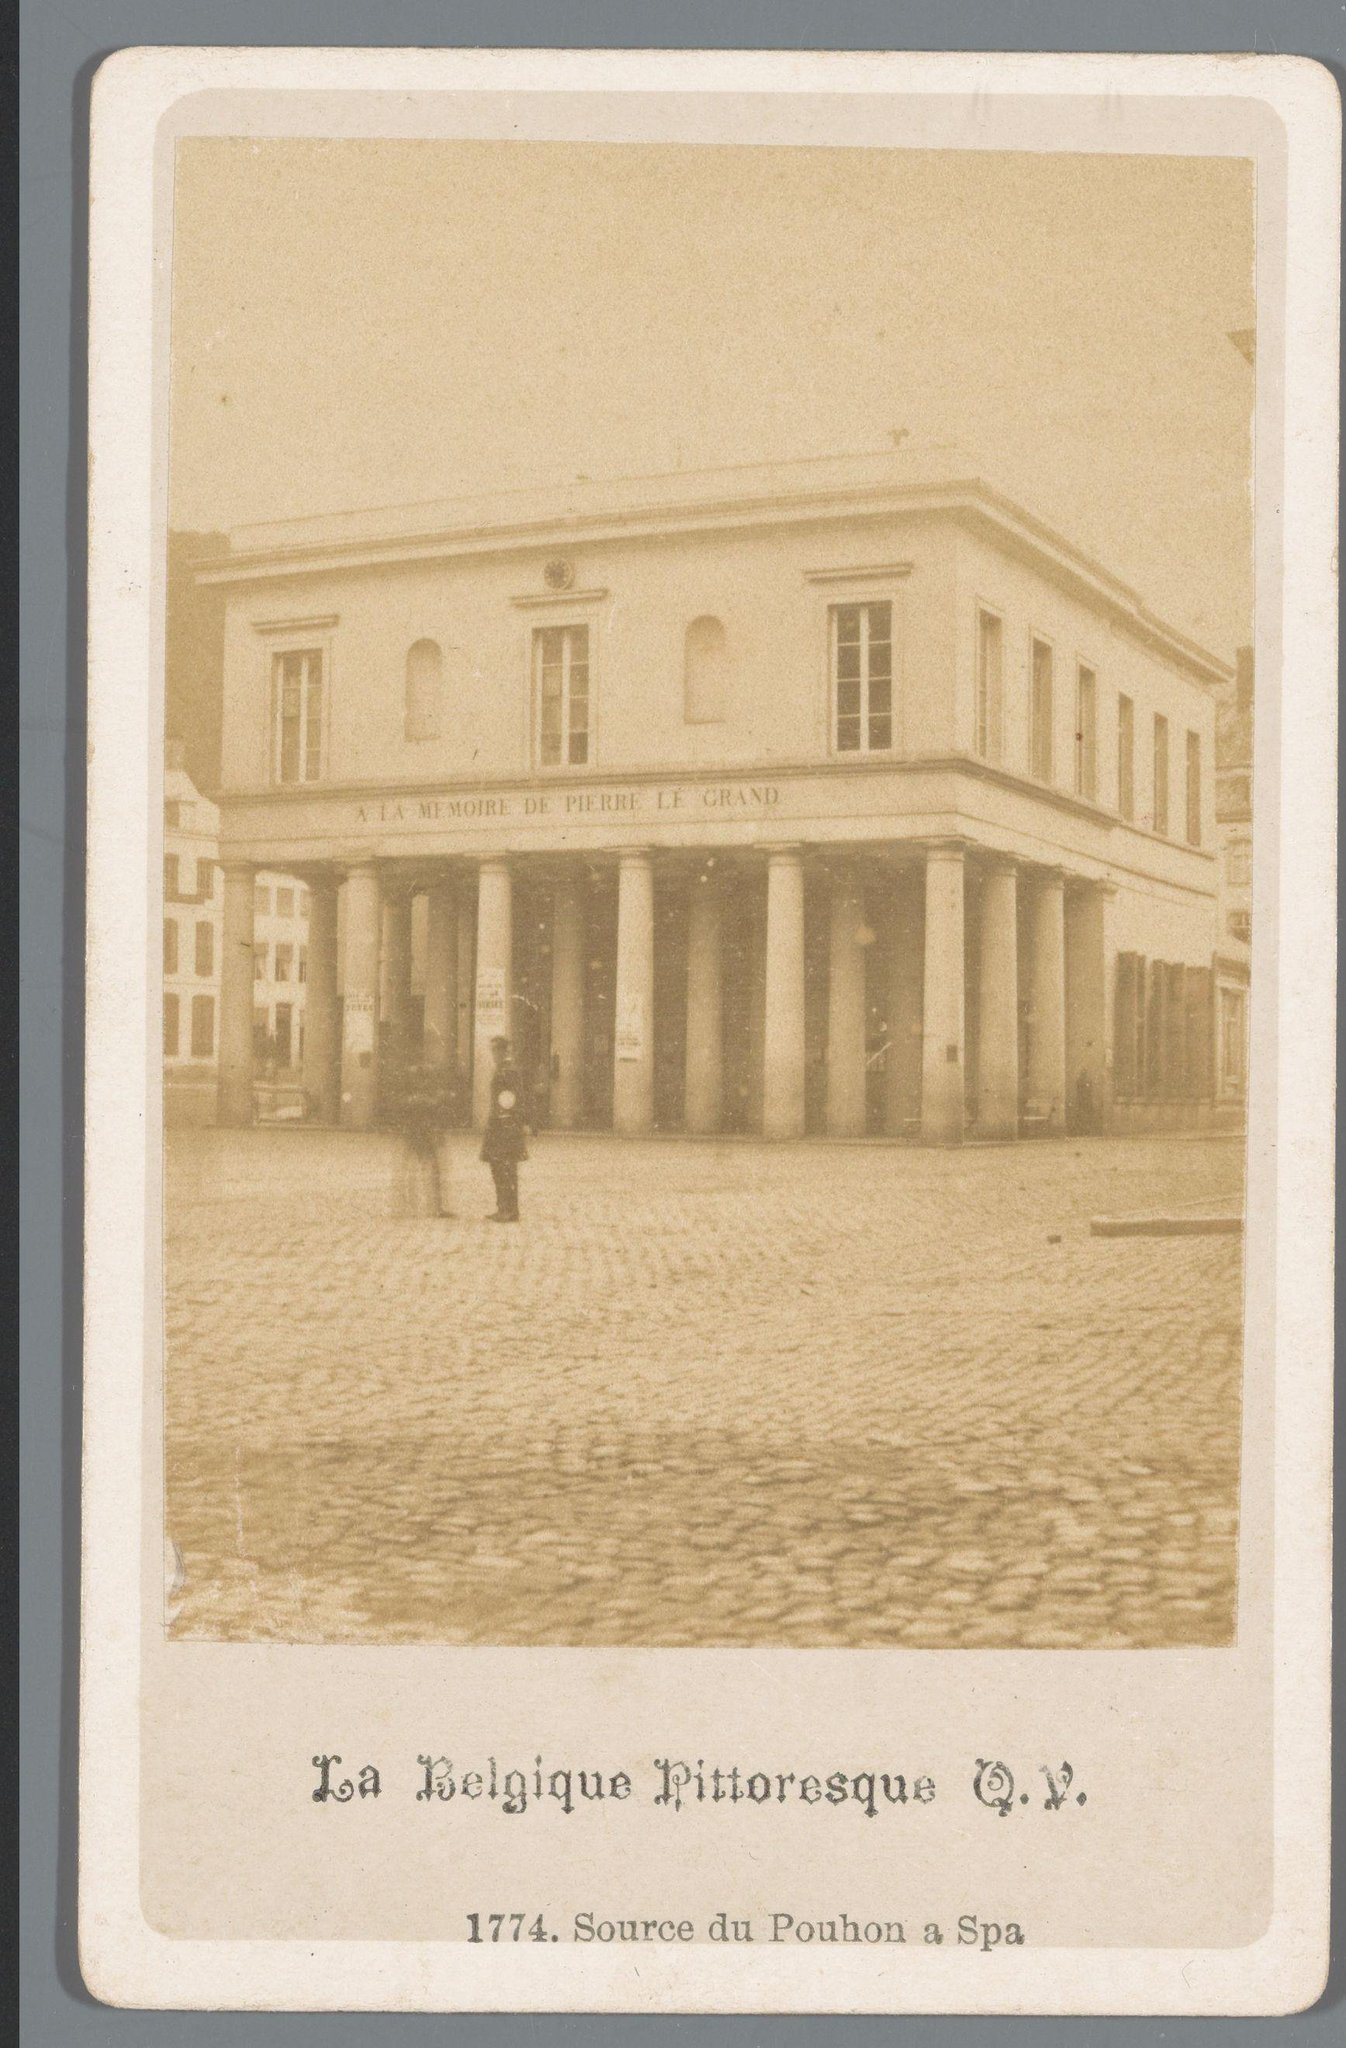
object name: photograph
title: Peter-de-Grotebron in Spa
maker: jules hippolyte quéval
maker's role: publisher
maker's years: 1824-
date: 1872-1875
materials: cardboard, paper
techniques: albumen print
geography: spa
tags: medicinal spring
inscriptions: number: ‘1774.’